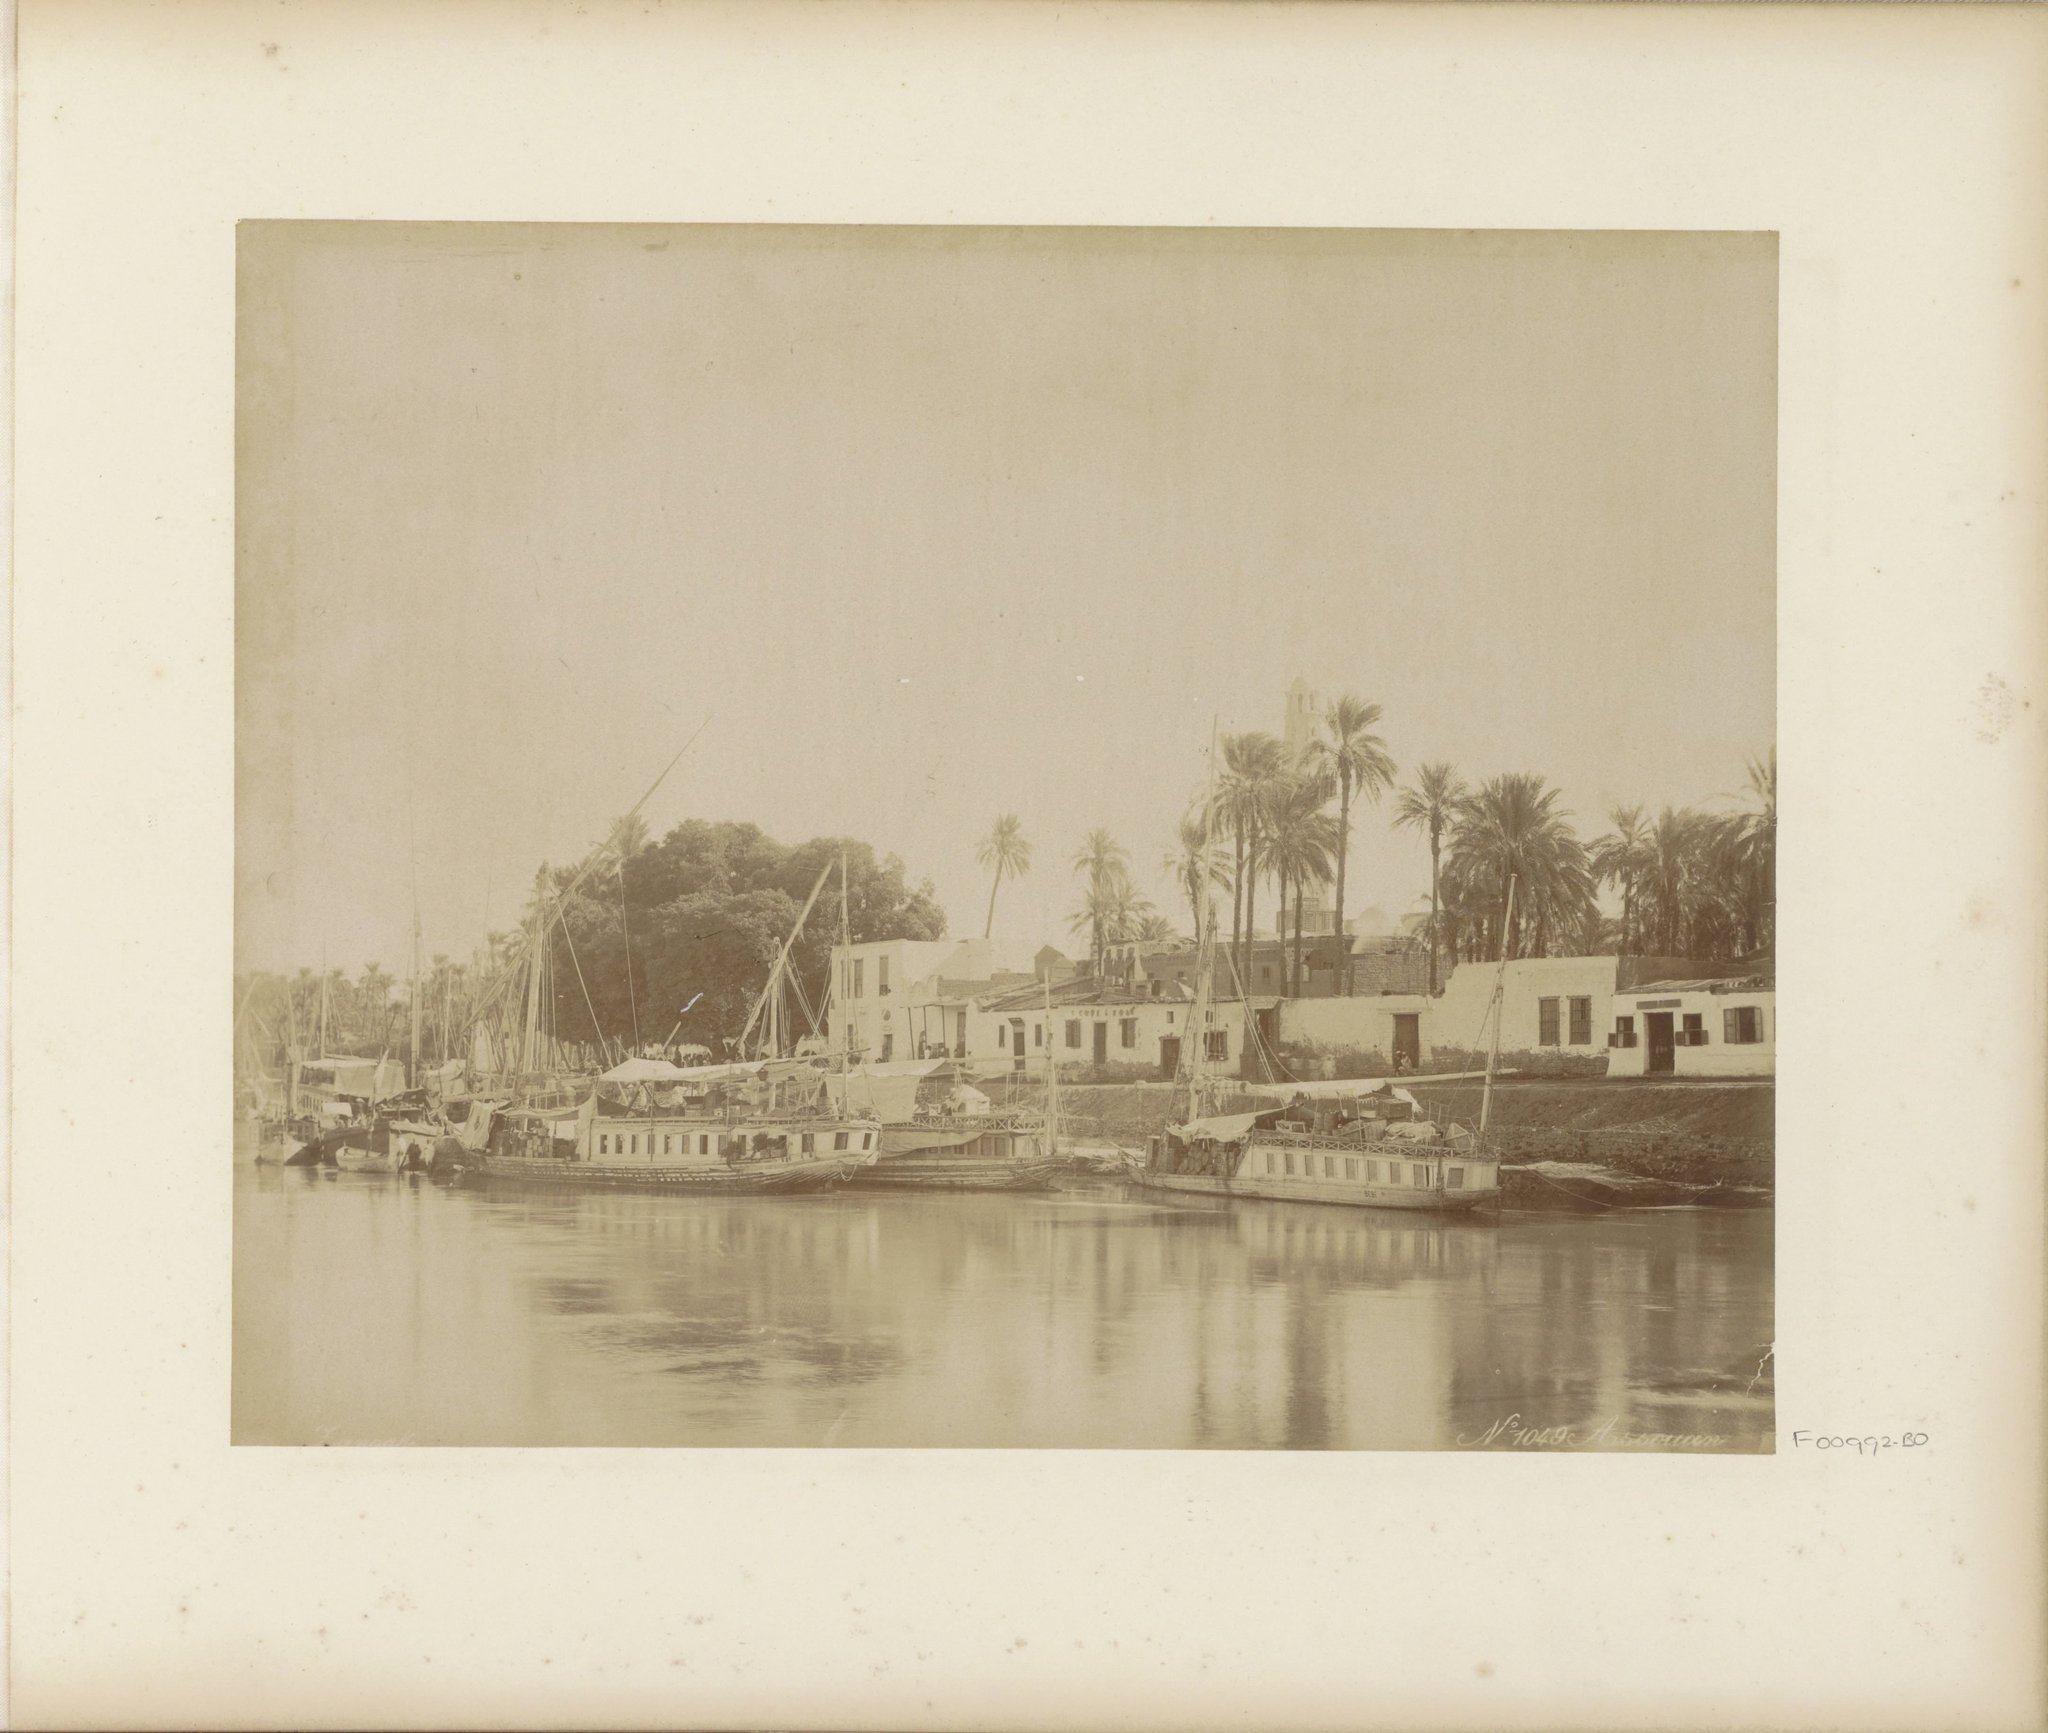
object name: photograph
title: Assouan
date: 1870-1890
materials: cardboard, paper, photographic support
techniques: albumen print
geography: aswan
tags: sailing-ship, sailing-boat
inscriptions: negative number: ‘1049’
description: Onderdeel van Reisalbum met 80 foto's van Egypte.